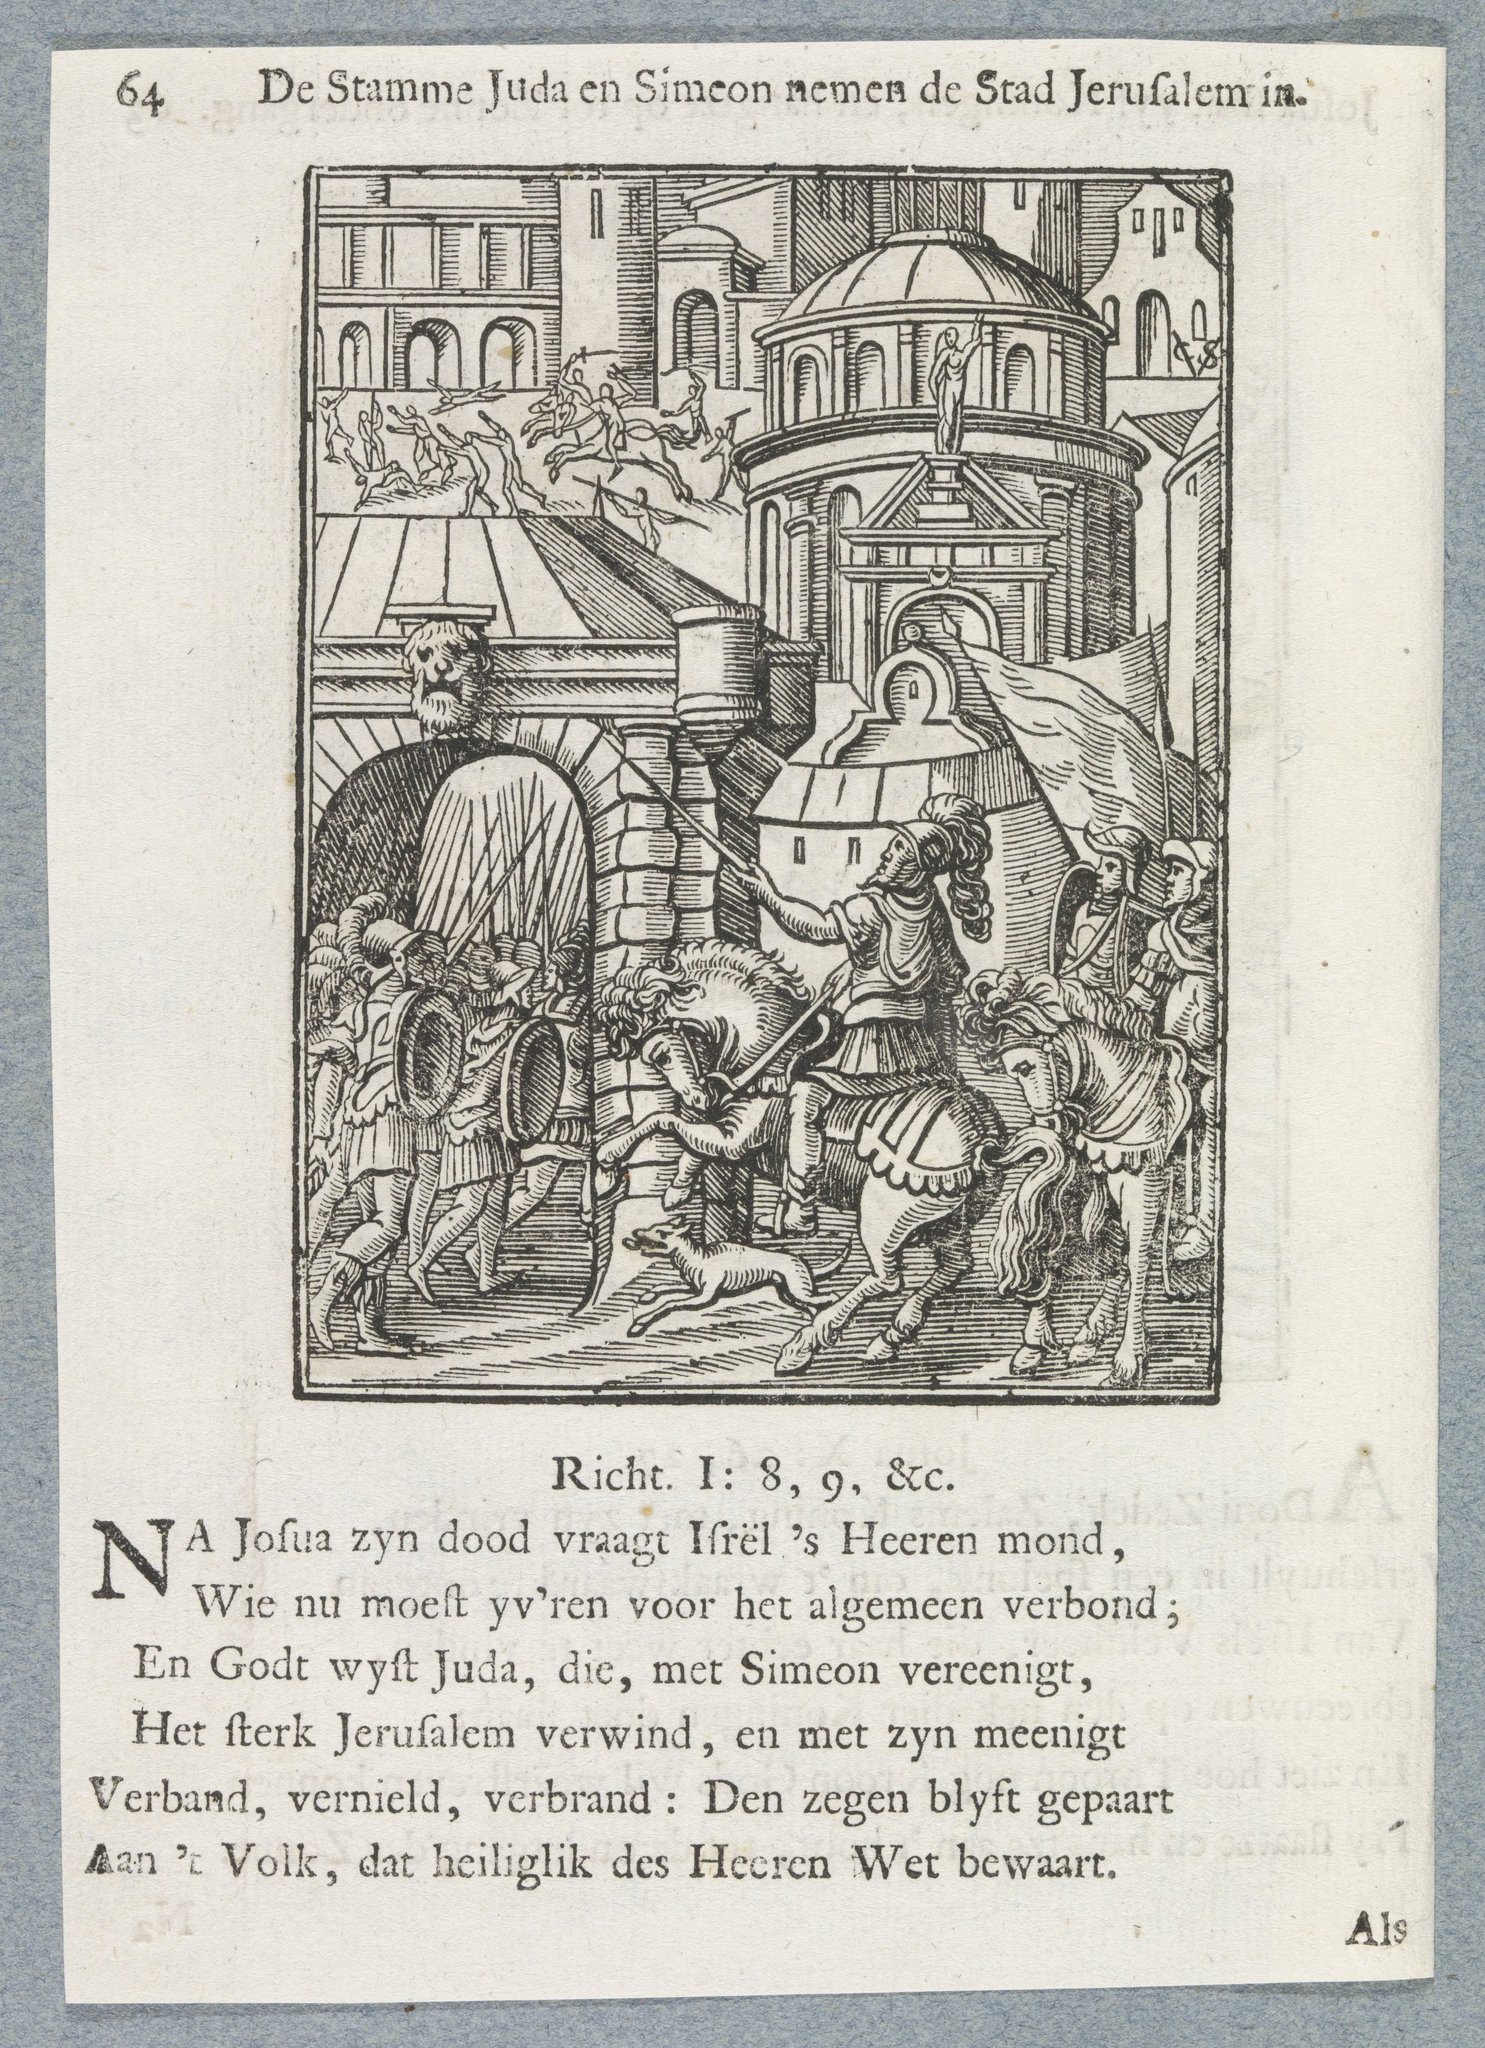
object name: album leaf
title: Stammen van Juda en Simoen nemen Jeruzalem in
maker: jan klooster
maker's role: bookseller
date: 1645-1646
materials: paper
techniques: letterpress printing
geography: amsterdam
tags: the tribes of judah and simeon defeat the canaanites and perizzites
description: De prent is afkomstig uit: Bybels Lusthof. Amsterdam, J. Klooster, 1740. De prent werd gemaakt voor de uitgaven van P.J. Paets uit Amsterdam. Ze komt in ieder geval voor in: Bibels Tresoor ofte der zielen lusthof. Amsterdam, P.J. Paets, 1646. Mogelijk staat ze ook in: Historien ende Prophetien. [Amsterdam], P.J. Paets, 1645.